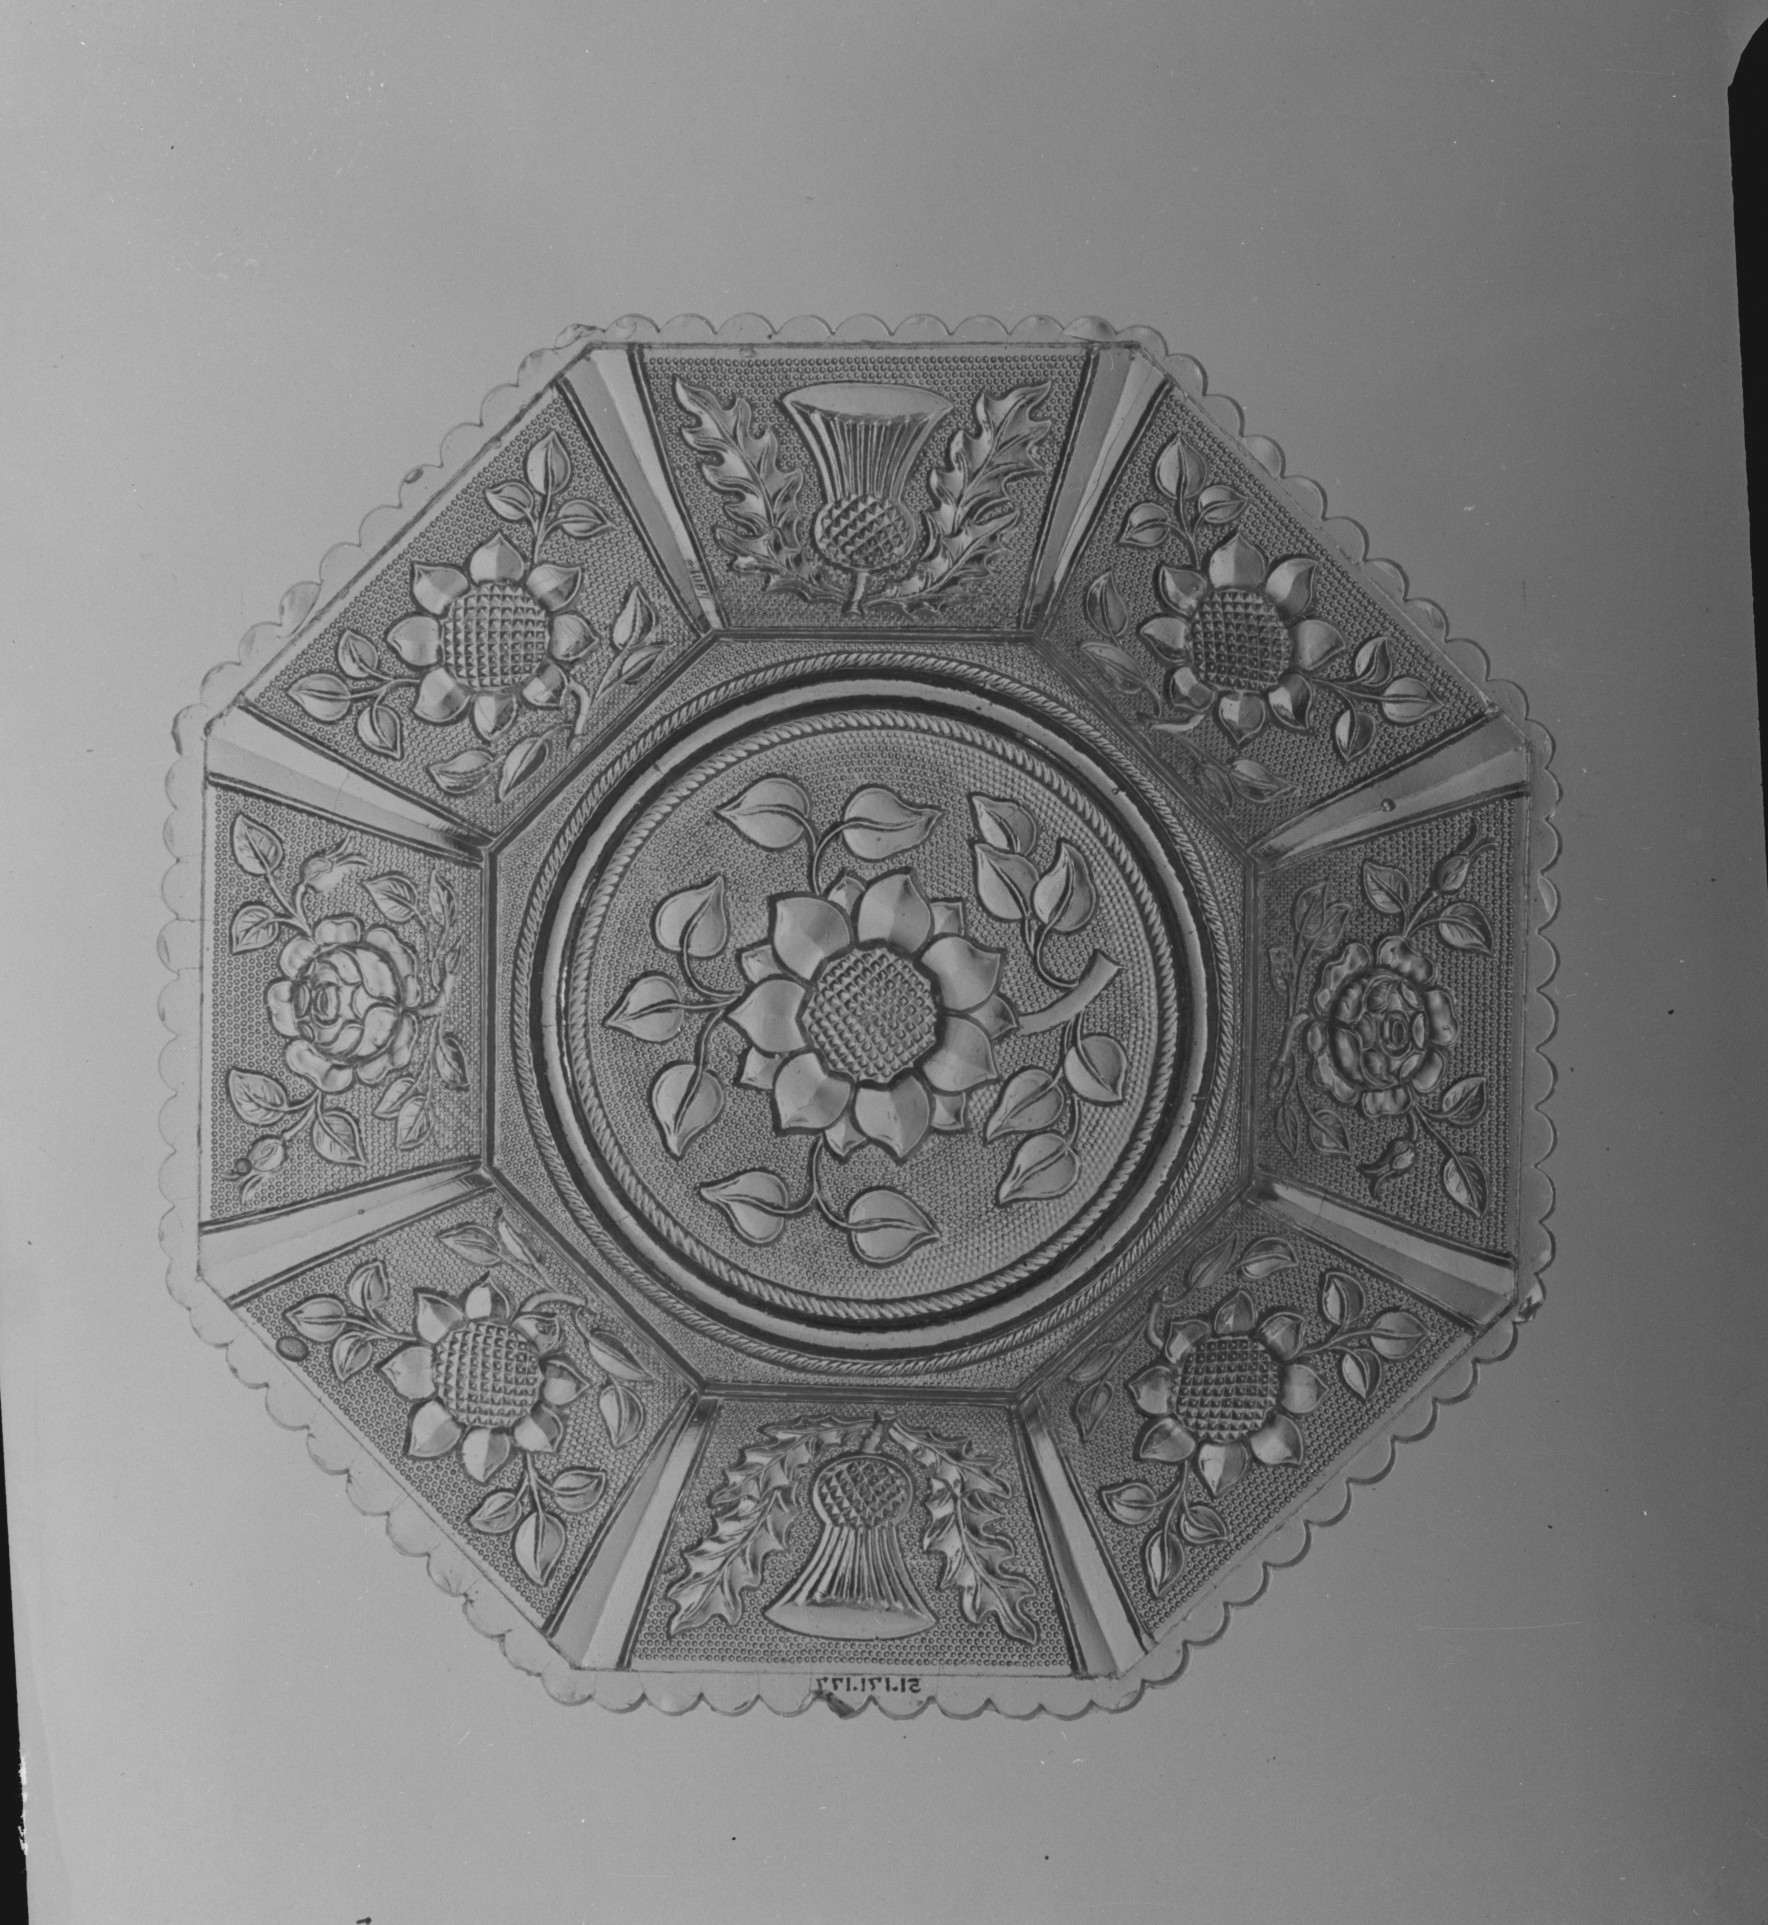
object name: bowl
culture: american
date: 1835-1850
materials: glass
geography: united states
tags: flowers